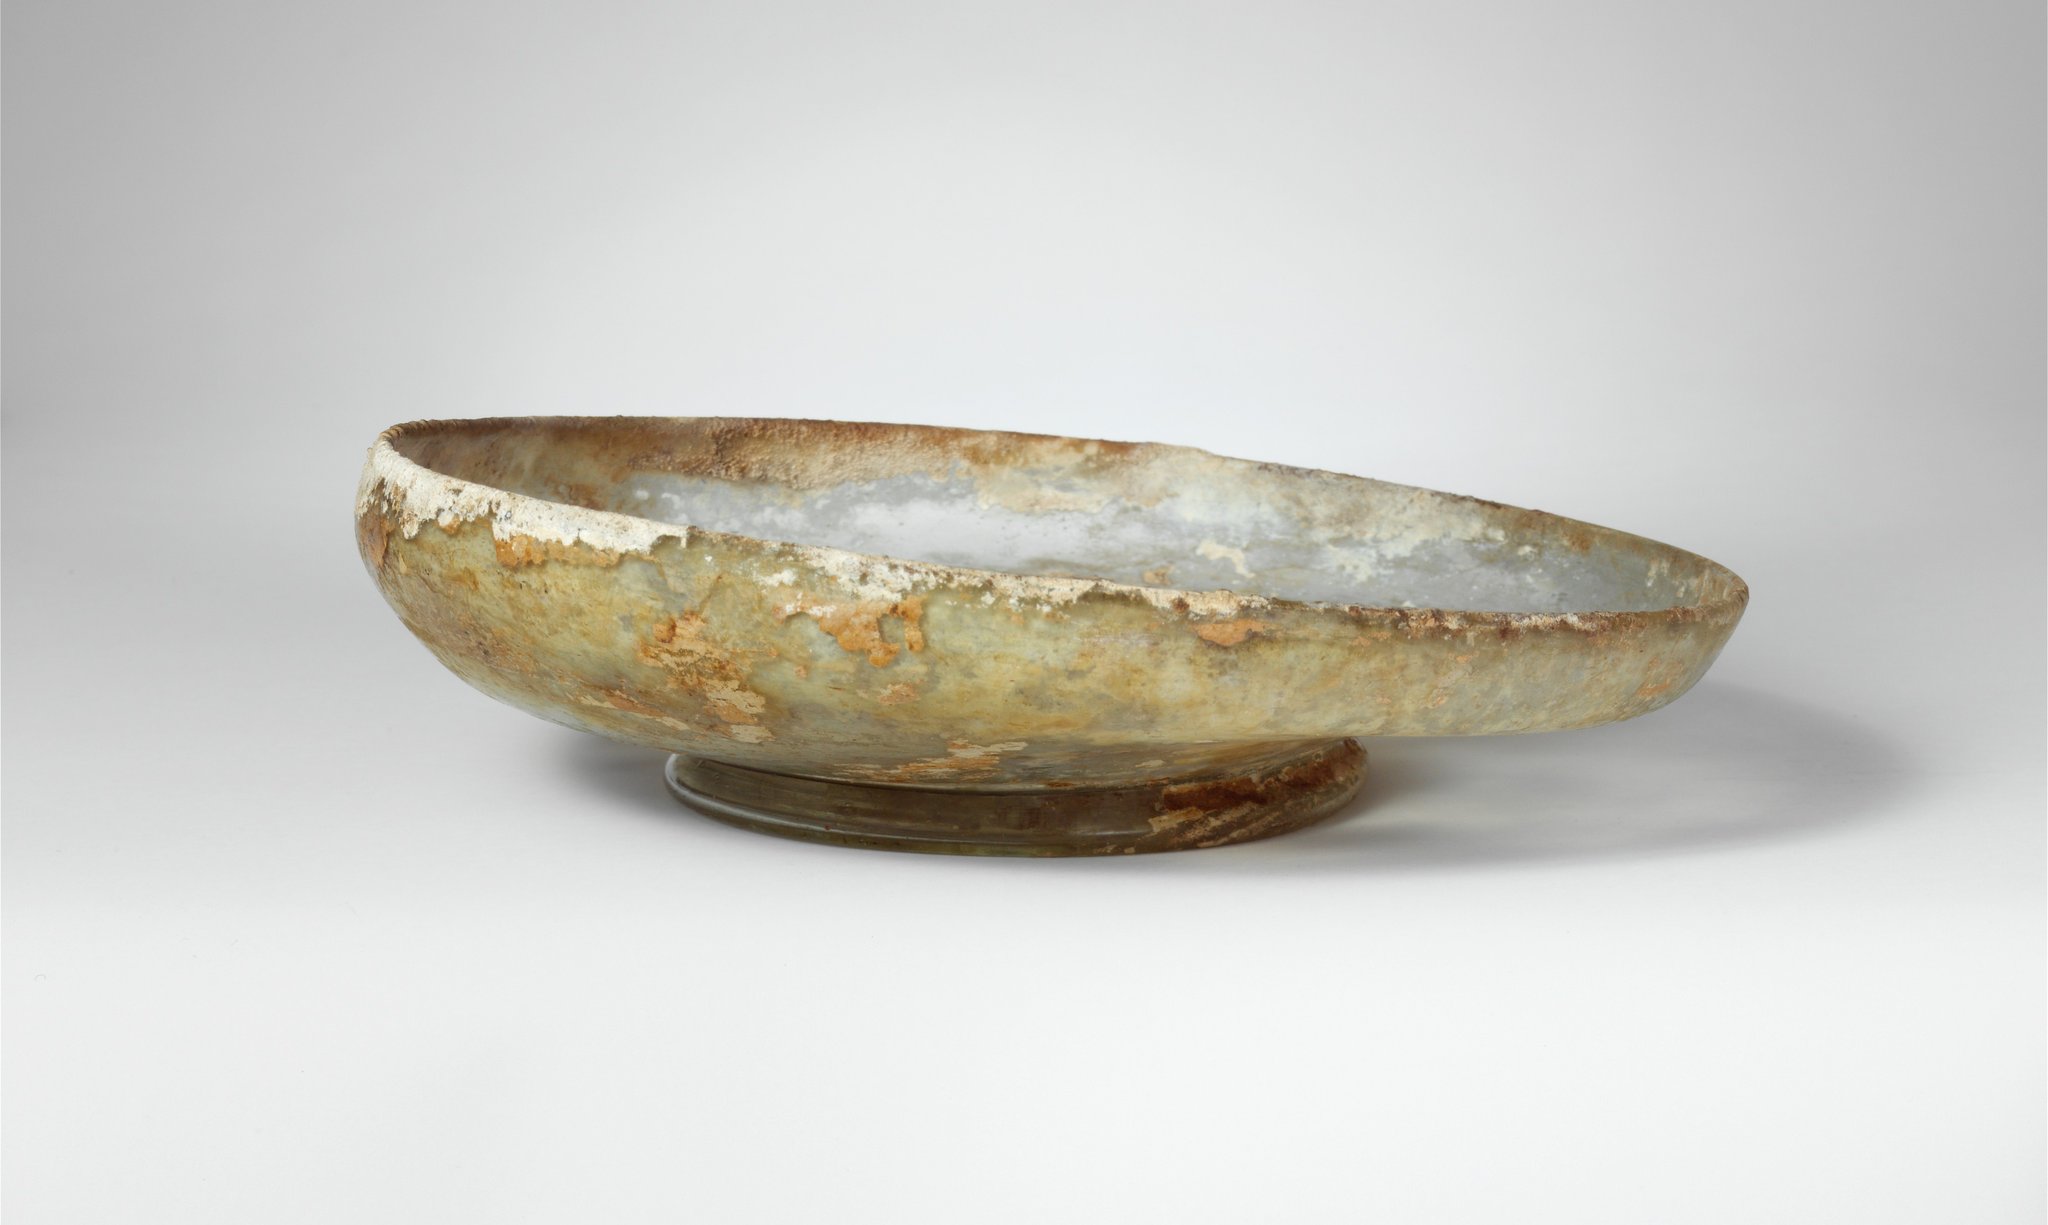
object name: dish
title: Glass dish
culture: roman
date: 301-400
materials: glass